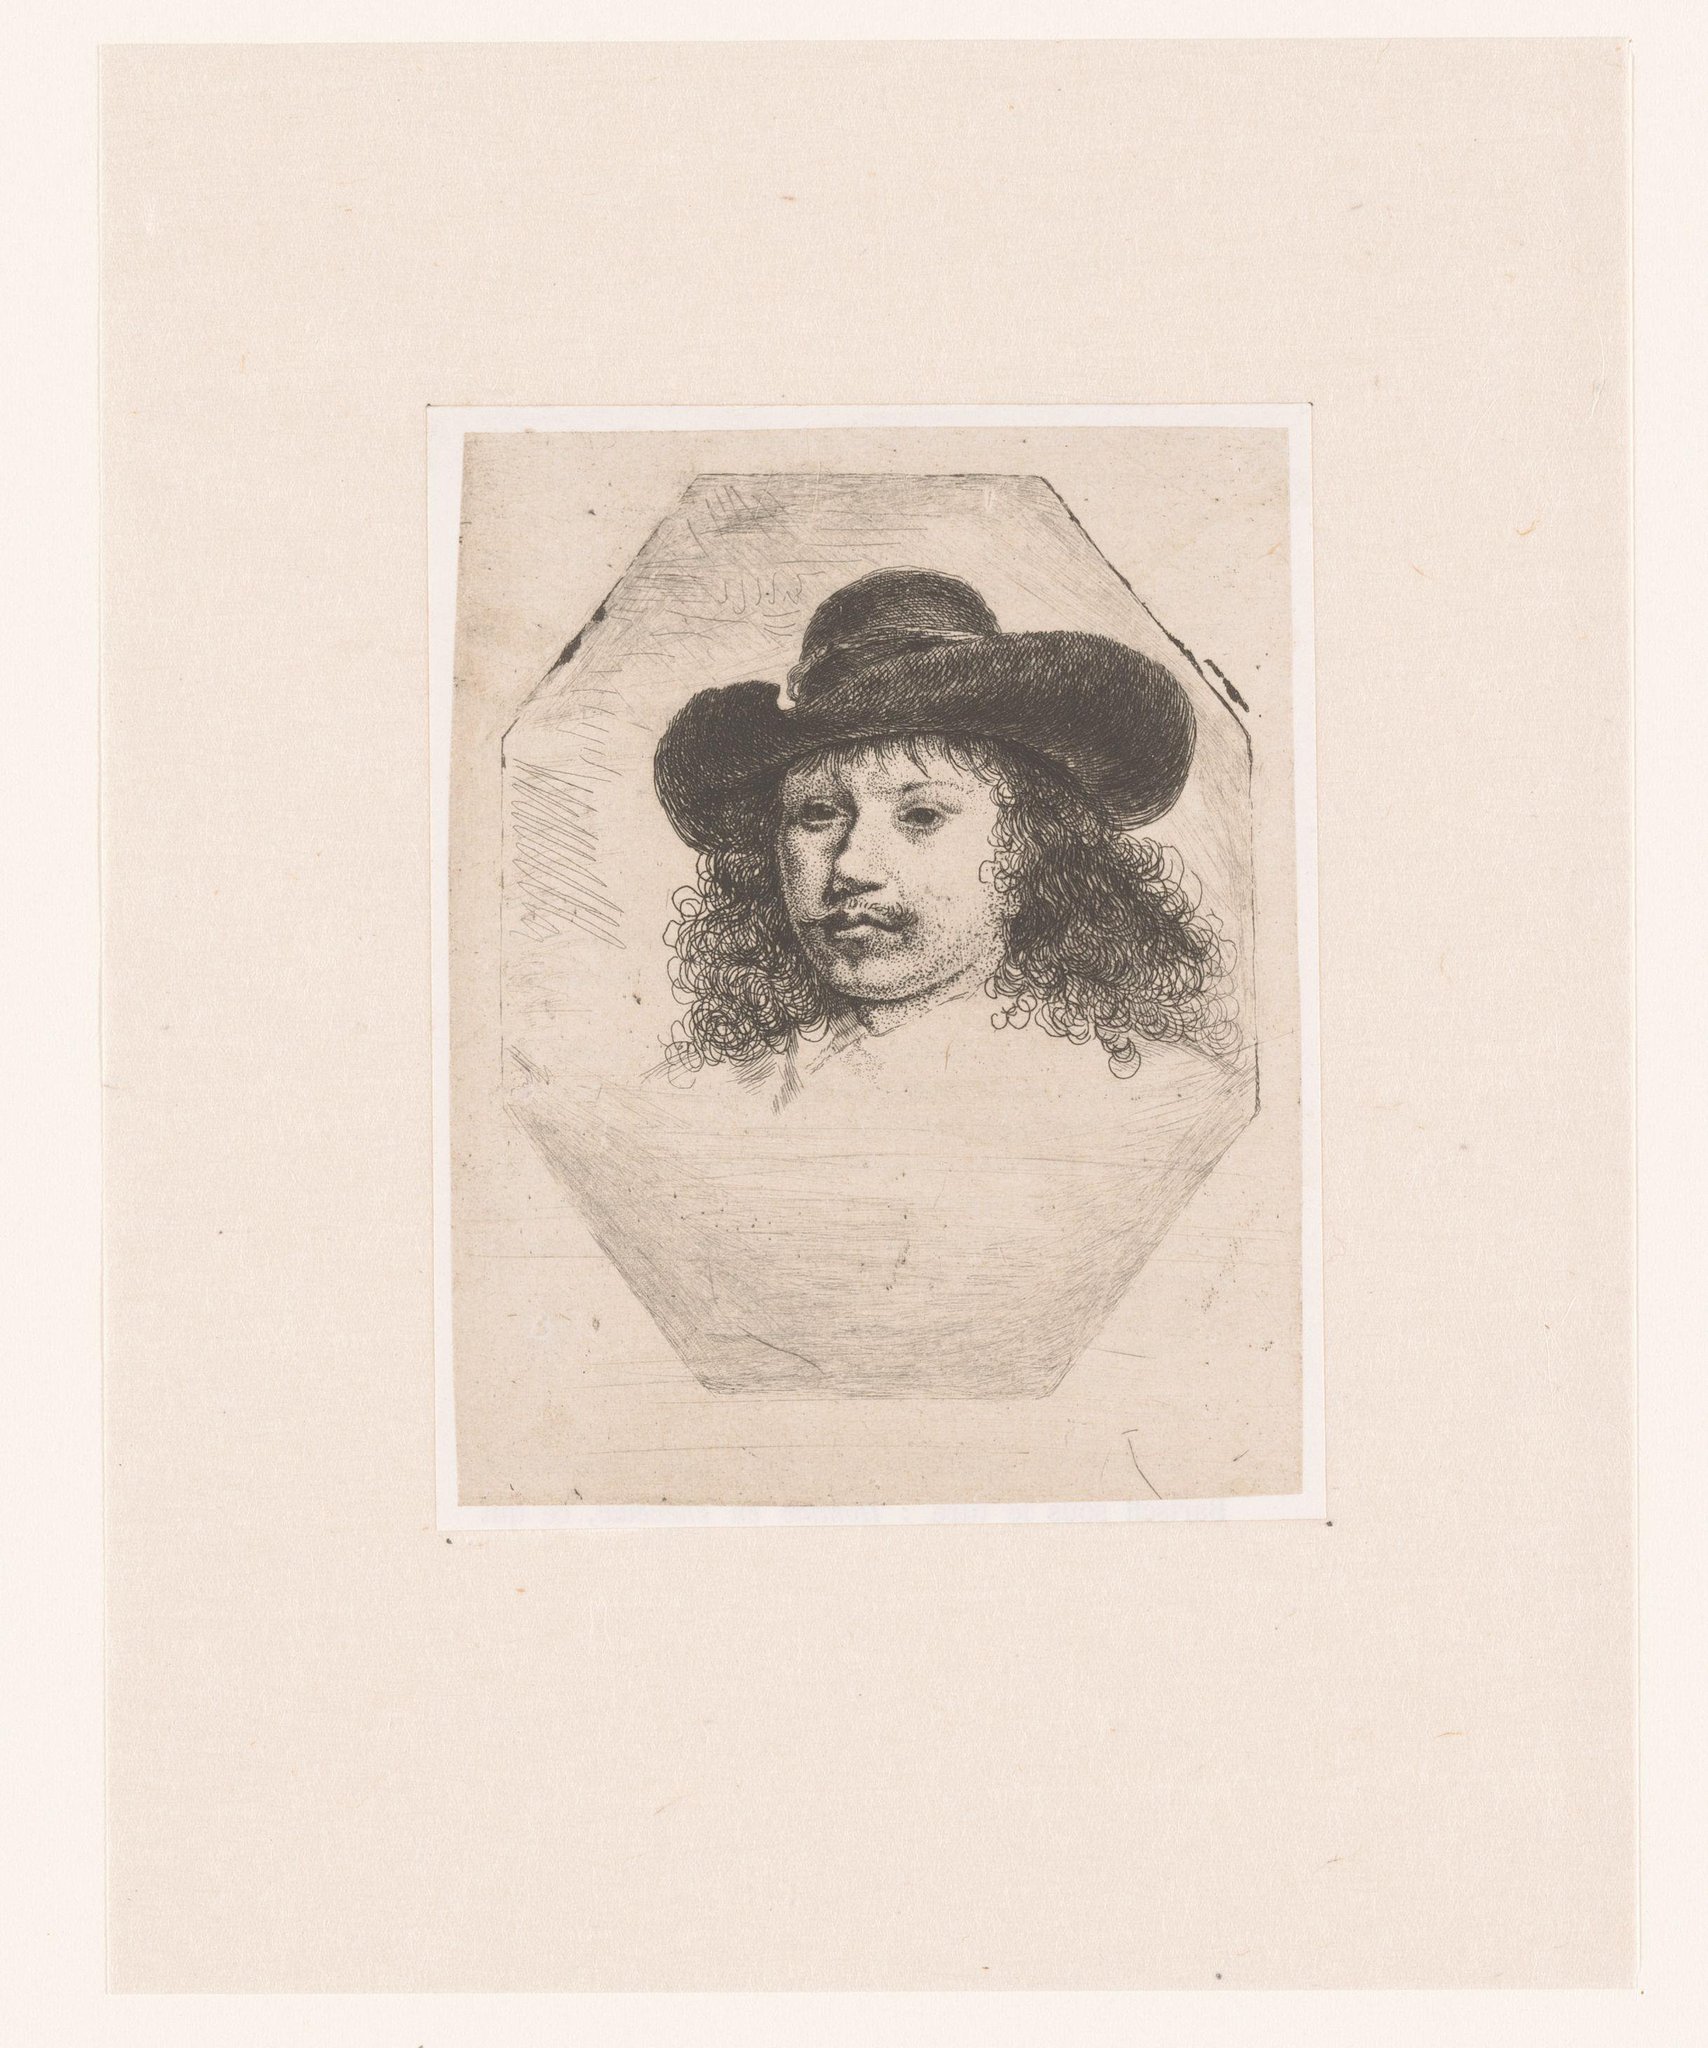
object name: print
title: Jongeman met een hoed met brede rand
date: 1859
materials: paper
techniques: etching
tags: youth, adolescent, head-gear: hat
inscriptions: collector's mark: Lugt 2228, : Lugt 2760